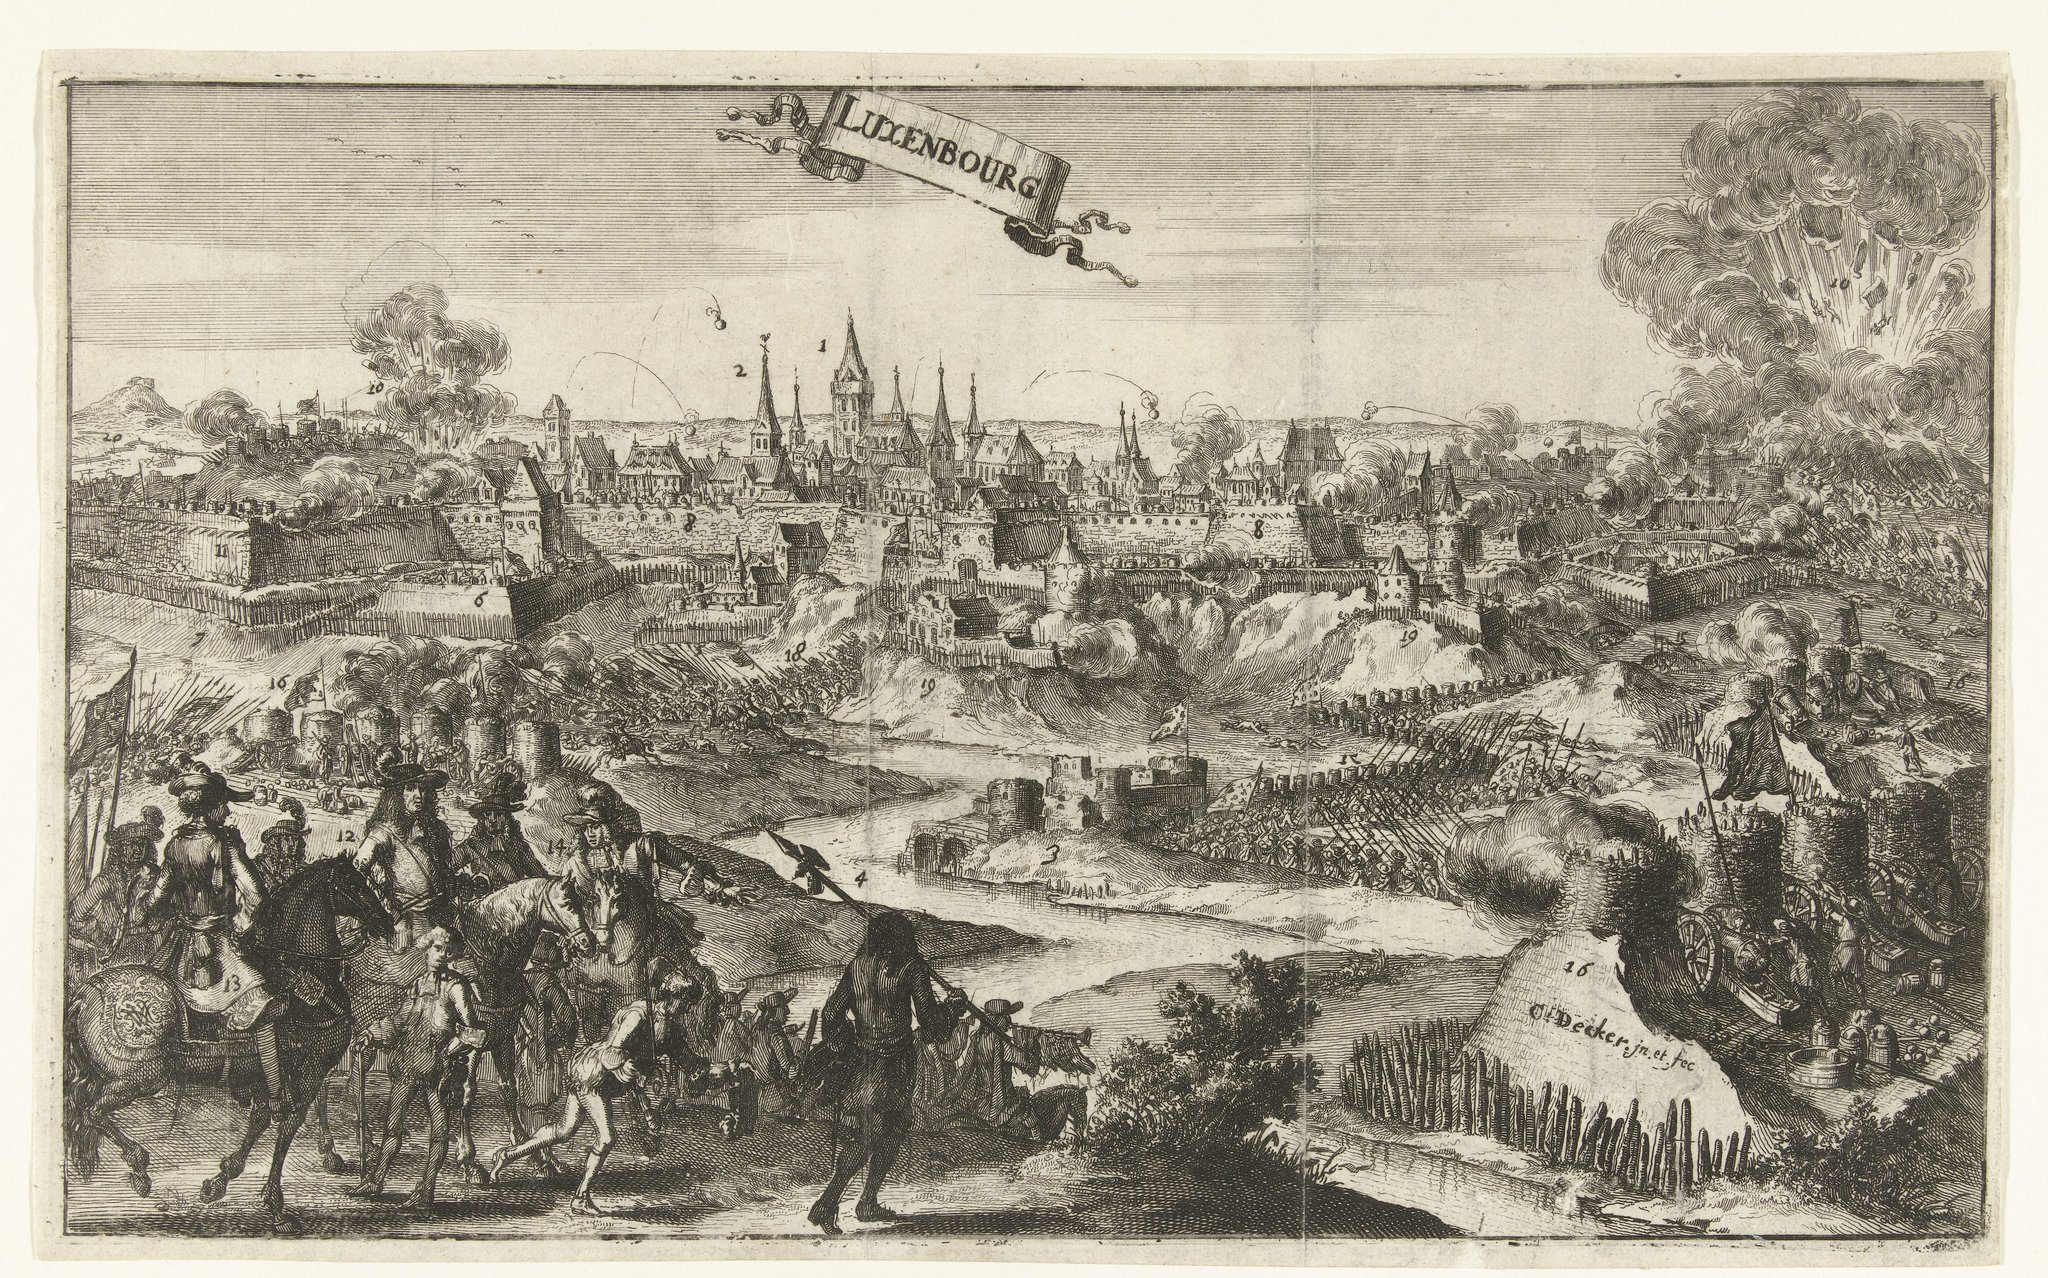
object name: print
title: Beleg van Luxemburg door de Fransen, 1684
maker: coenraet decker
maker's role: print maker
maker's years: 1650-1685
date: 1684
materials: paper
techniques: etching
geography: northern netherlands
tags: paris, capture of city (after the siege)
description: Beleg van Luxemburg door het Franse leger onder maarschalk François de Créquy en de marquis de Vauban, veroverd op 4 juni 1684. Gezicht op het bombardement van de stad, op de voorgrond de Franse bevelhebbers te paard.